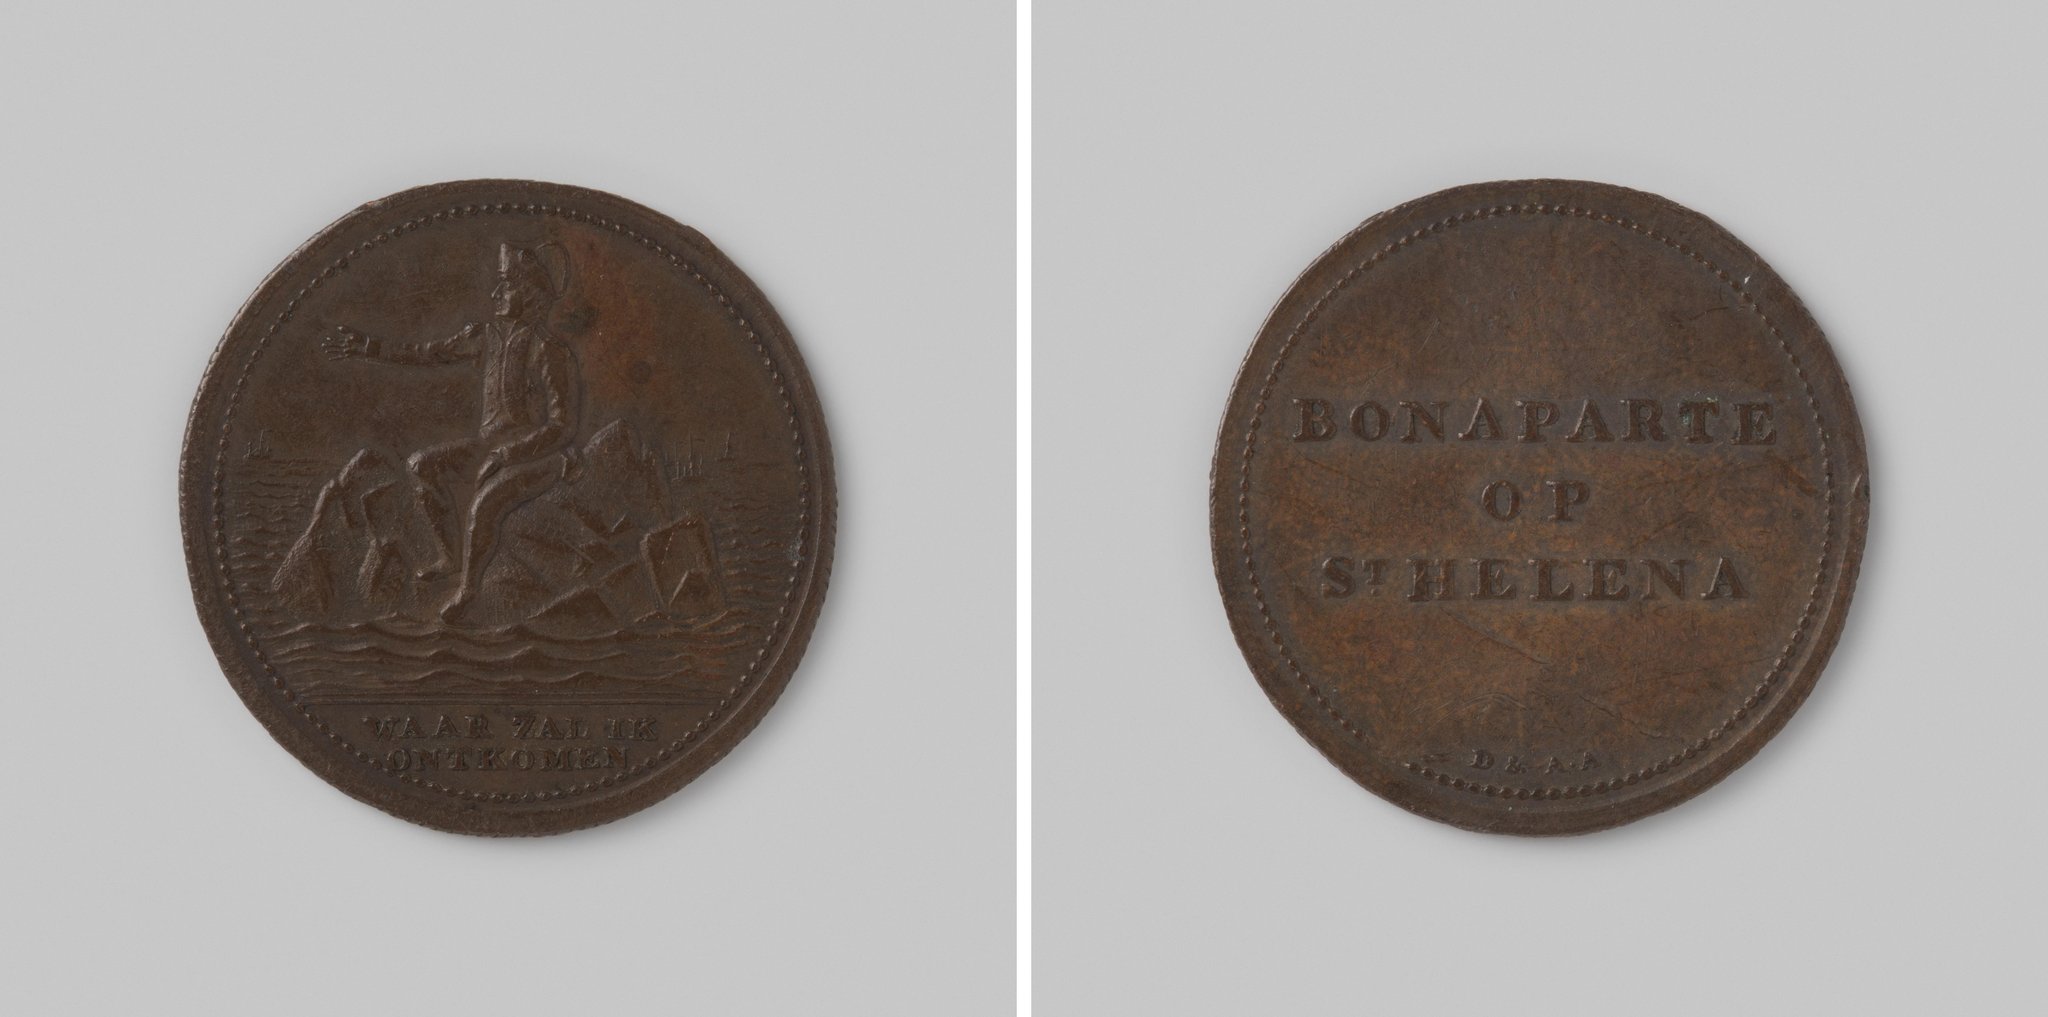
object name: history medal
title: Verbanning van Napoleon Bonaparte naar Sint Helena 1815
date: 1815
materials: copper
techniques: striking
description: Koperen penning, op de voorzijde Napoleon zittend op een steenklomp op zee, met afsnedetekst, op de keerzijde drie regels tekst.